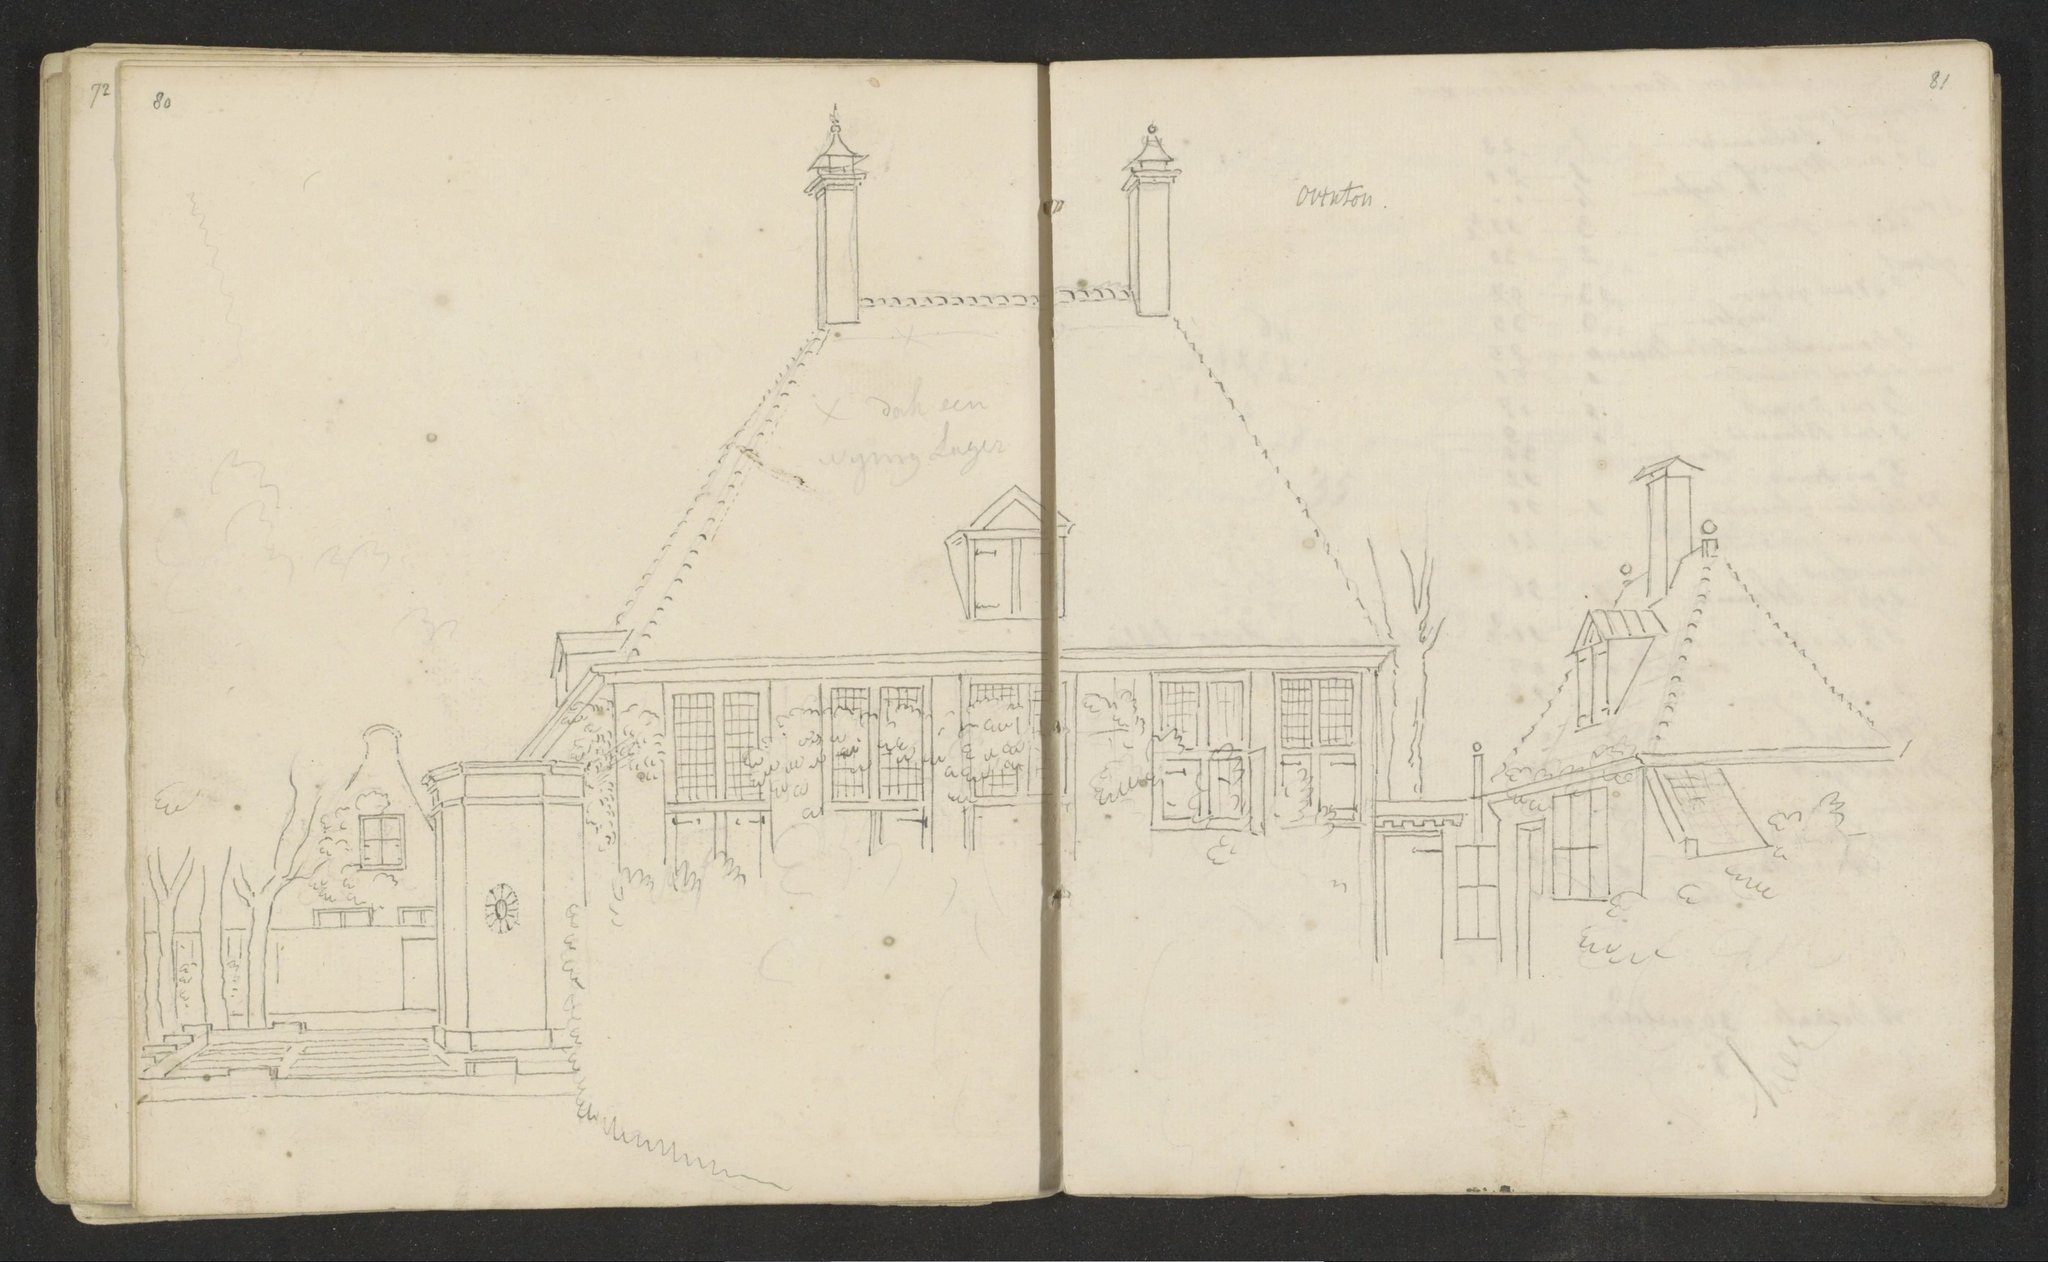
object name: sketchbook leaf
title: Hofstede Overton te Haarlem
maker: cornelis pronk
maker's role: draughtsman, painter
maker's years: 1691-1759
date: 1728-1732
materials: ink, paper, pencil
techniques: pen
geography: haarlem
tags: country-house, haarlem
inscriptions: annotation: ‘Overton/ dak een wijnig lager’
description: Bladzijde 80 en 81 uit een schetsboek met 96 bladzijden.